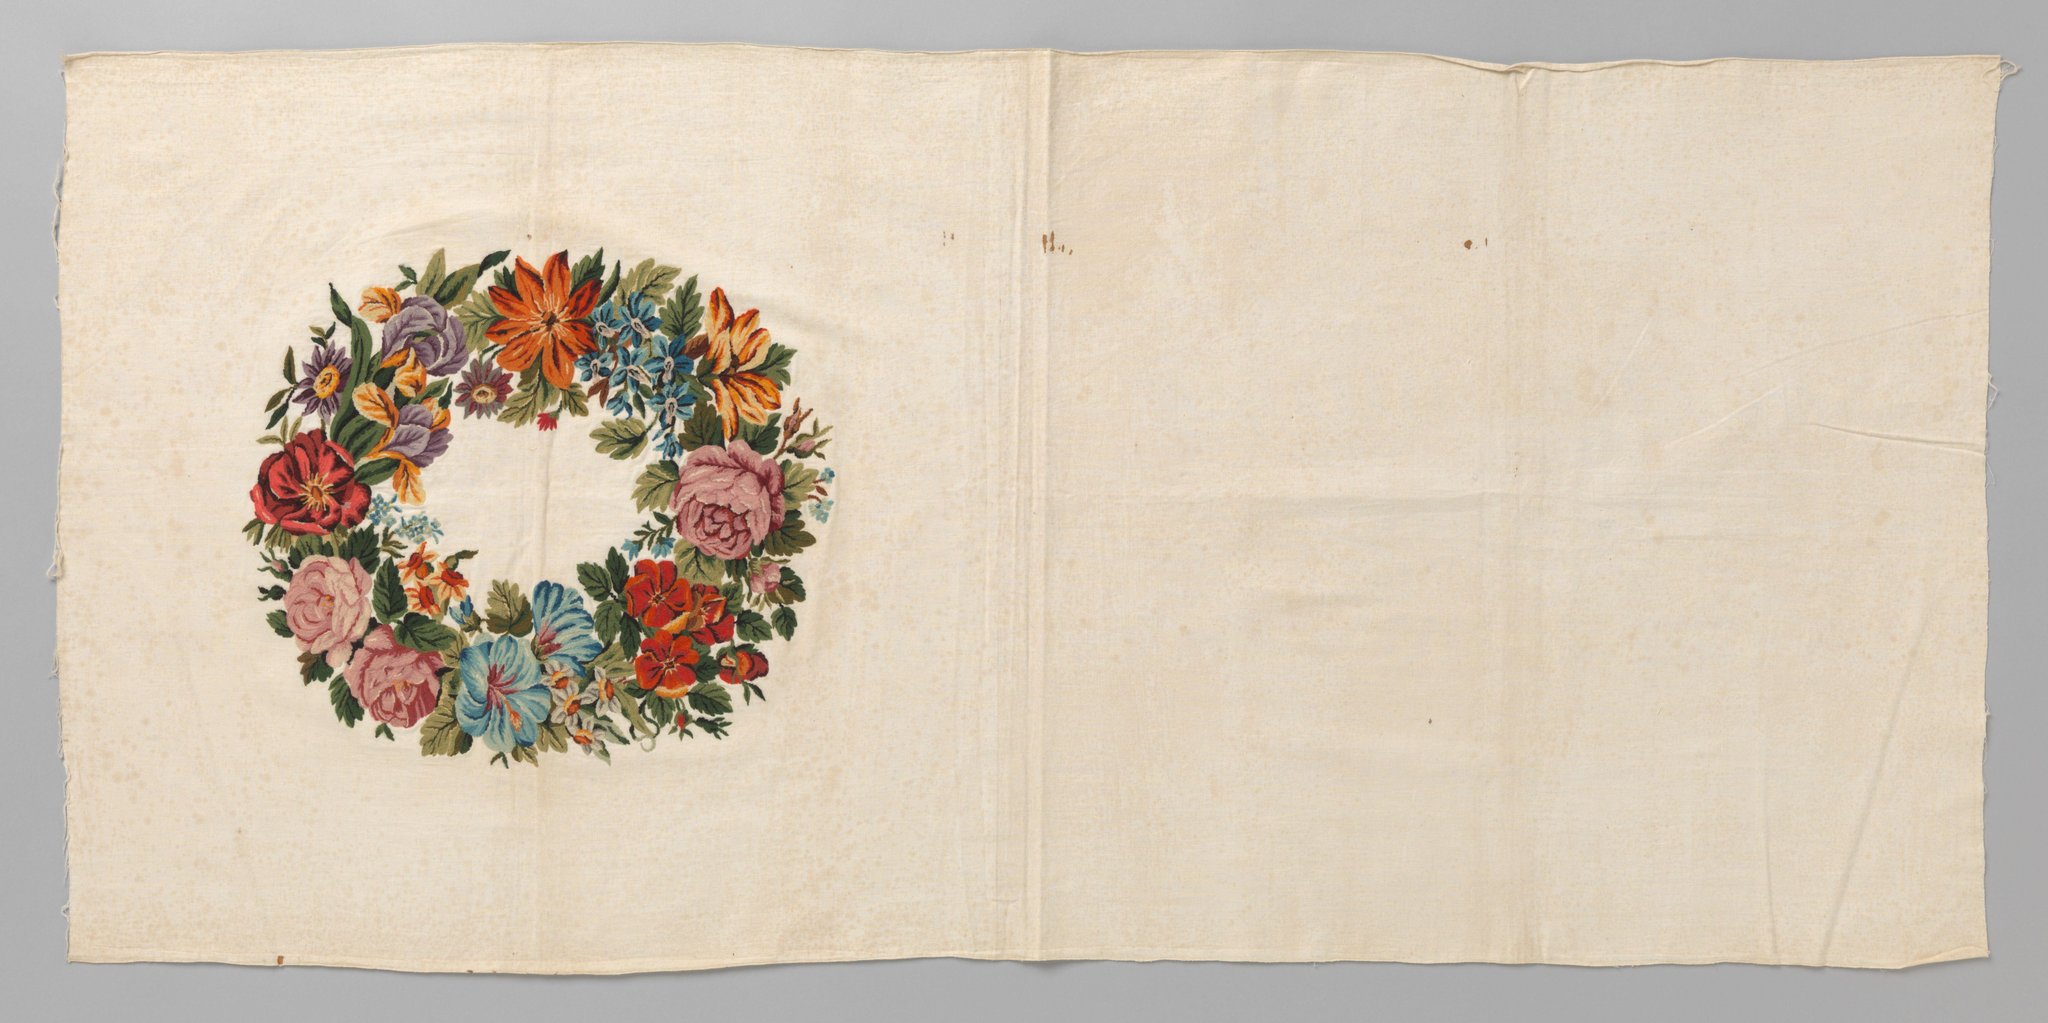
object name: bekledingsstof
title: Metrage bekledingsstof met borduurwerk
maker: Anonymous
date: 1850-1949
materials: cotton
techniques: weave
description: Metrage bekledingsstof, geborduurd met kleurige bloemenkransen in kettingsteek.